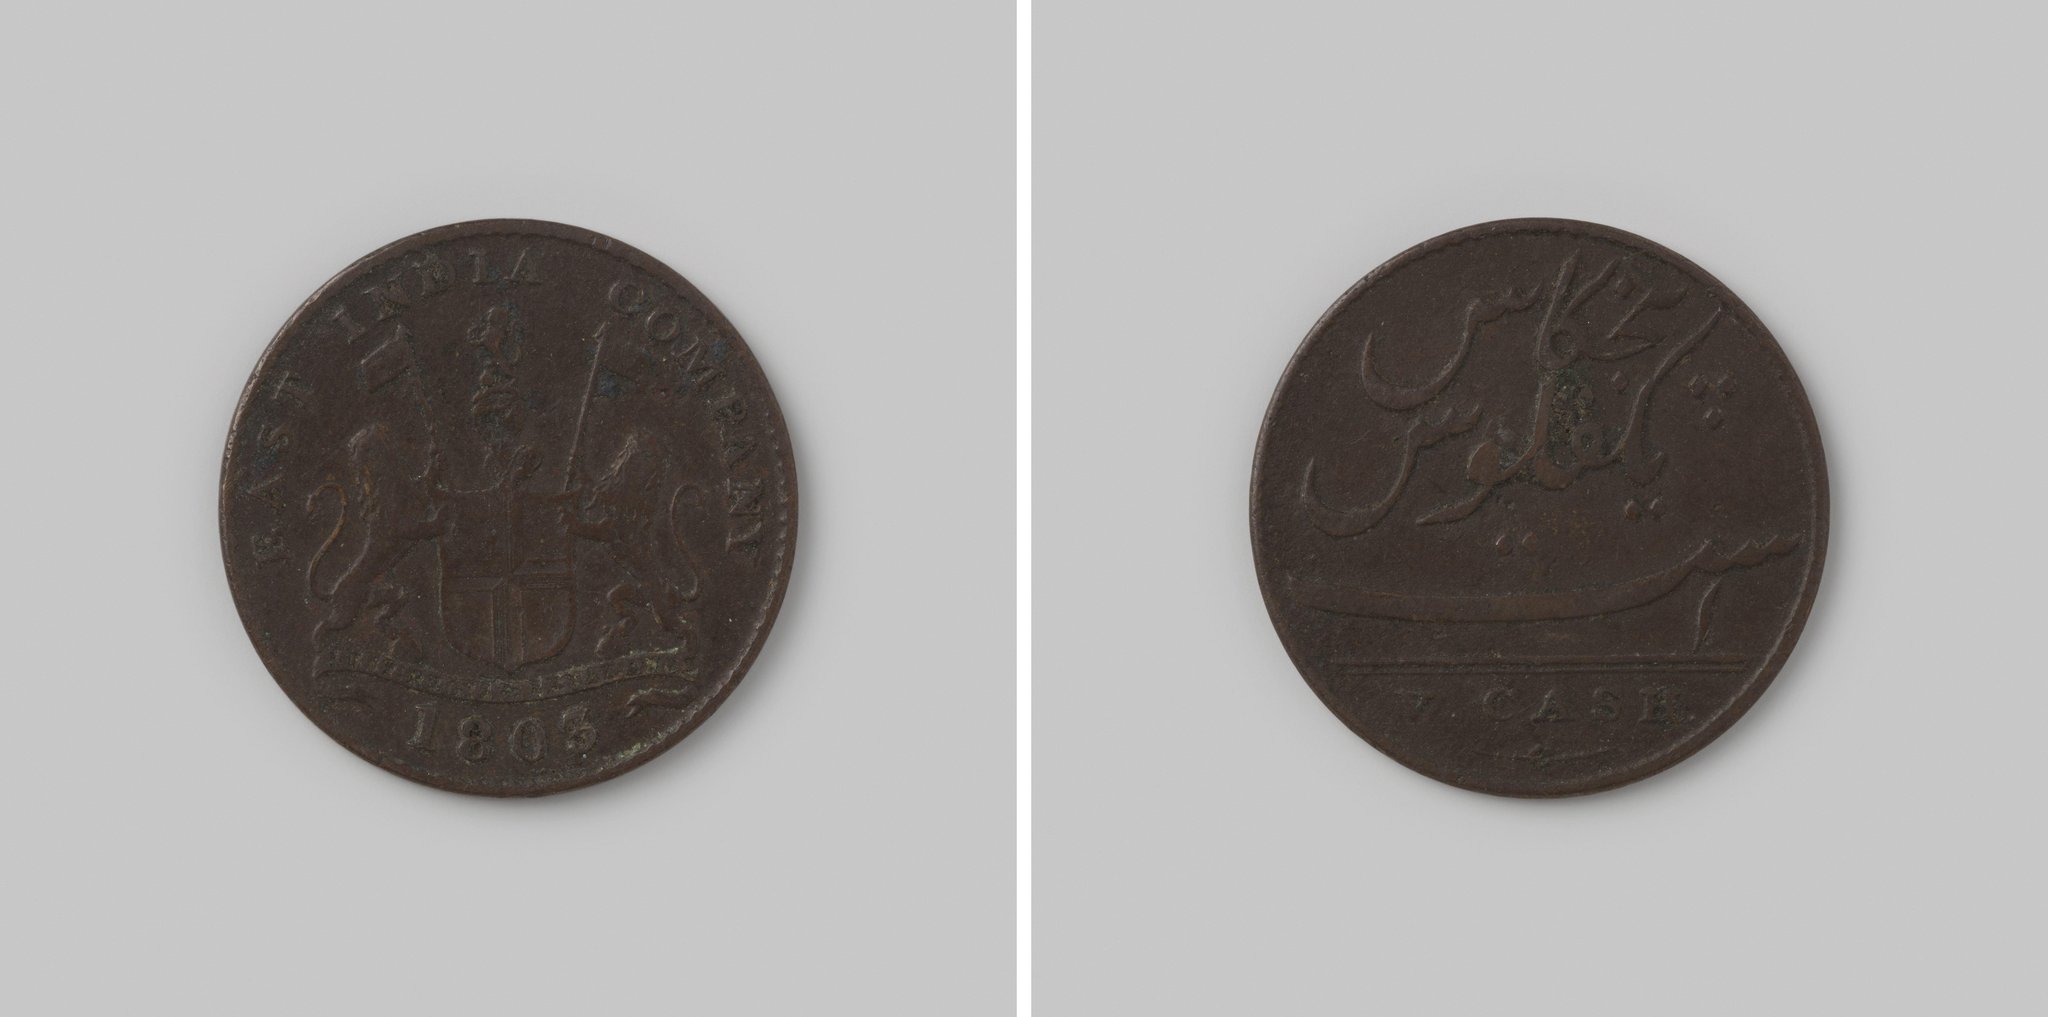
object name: coin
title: 5 cash voor Madras in India van de Engelse Oostindische Compagnie (EIC), 1803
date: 1803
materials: copper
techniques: striking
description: Koperen munt. Voorzijde: door twee op banderol, waarin opschrift, staande leeuwen met pijl, waaraan vlag in de klauw, gehouden wapenschild van de EIC, waarboven helmteken. Jaartal onderaan. Keerzijde: in Arabische lettertekens opschrift in drie regels. In afsnede waarde-aanduiding: V Cash. Gladde rand.